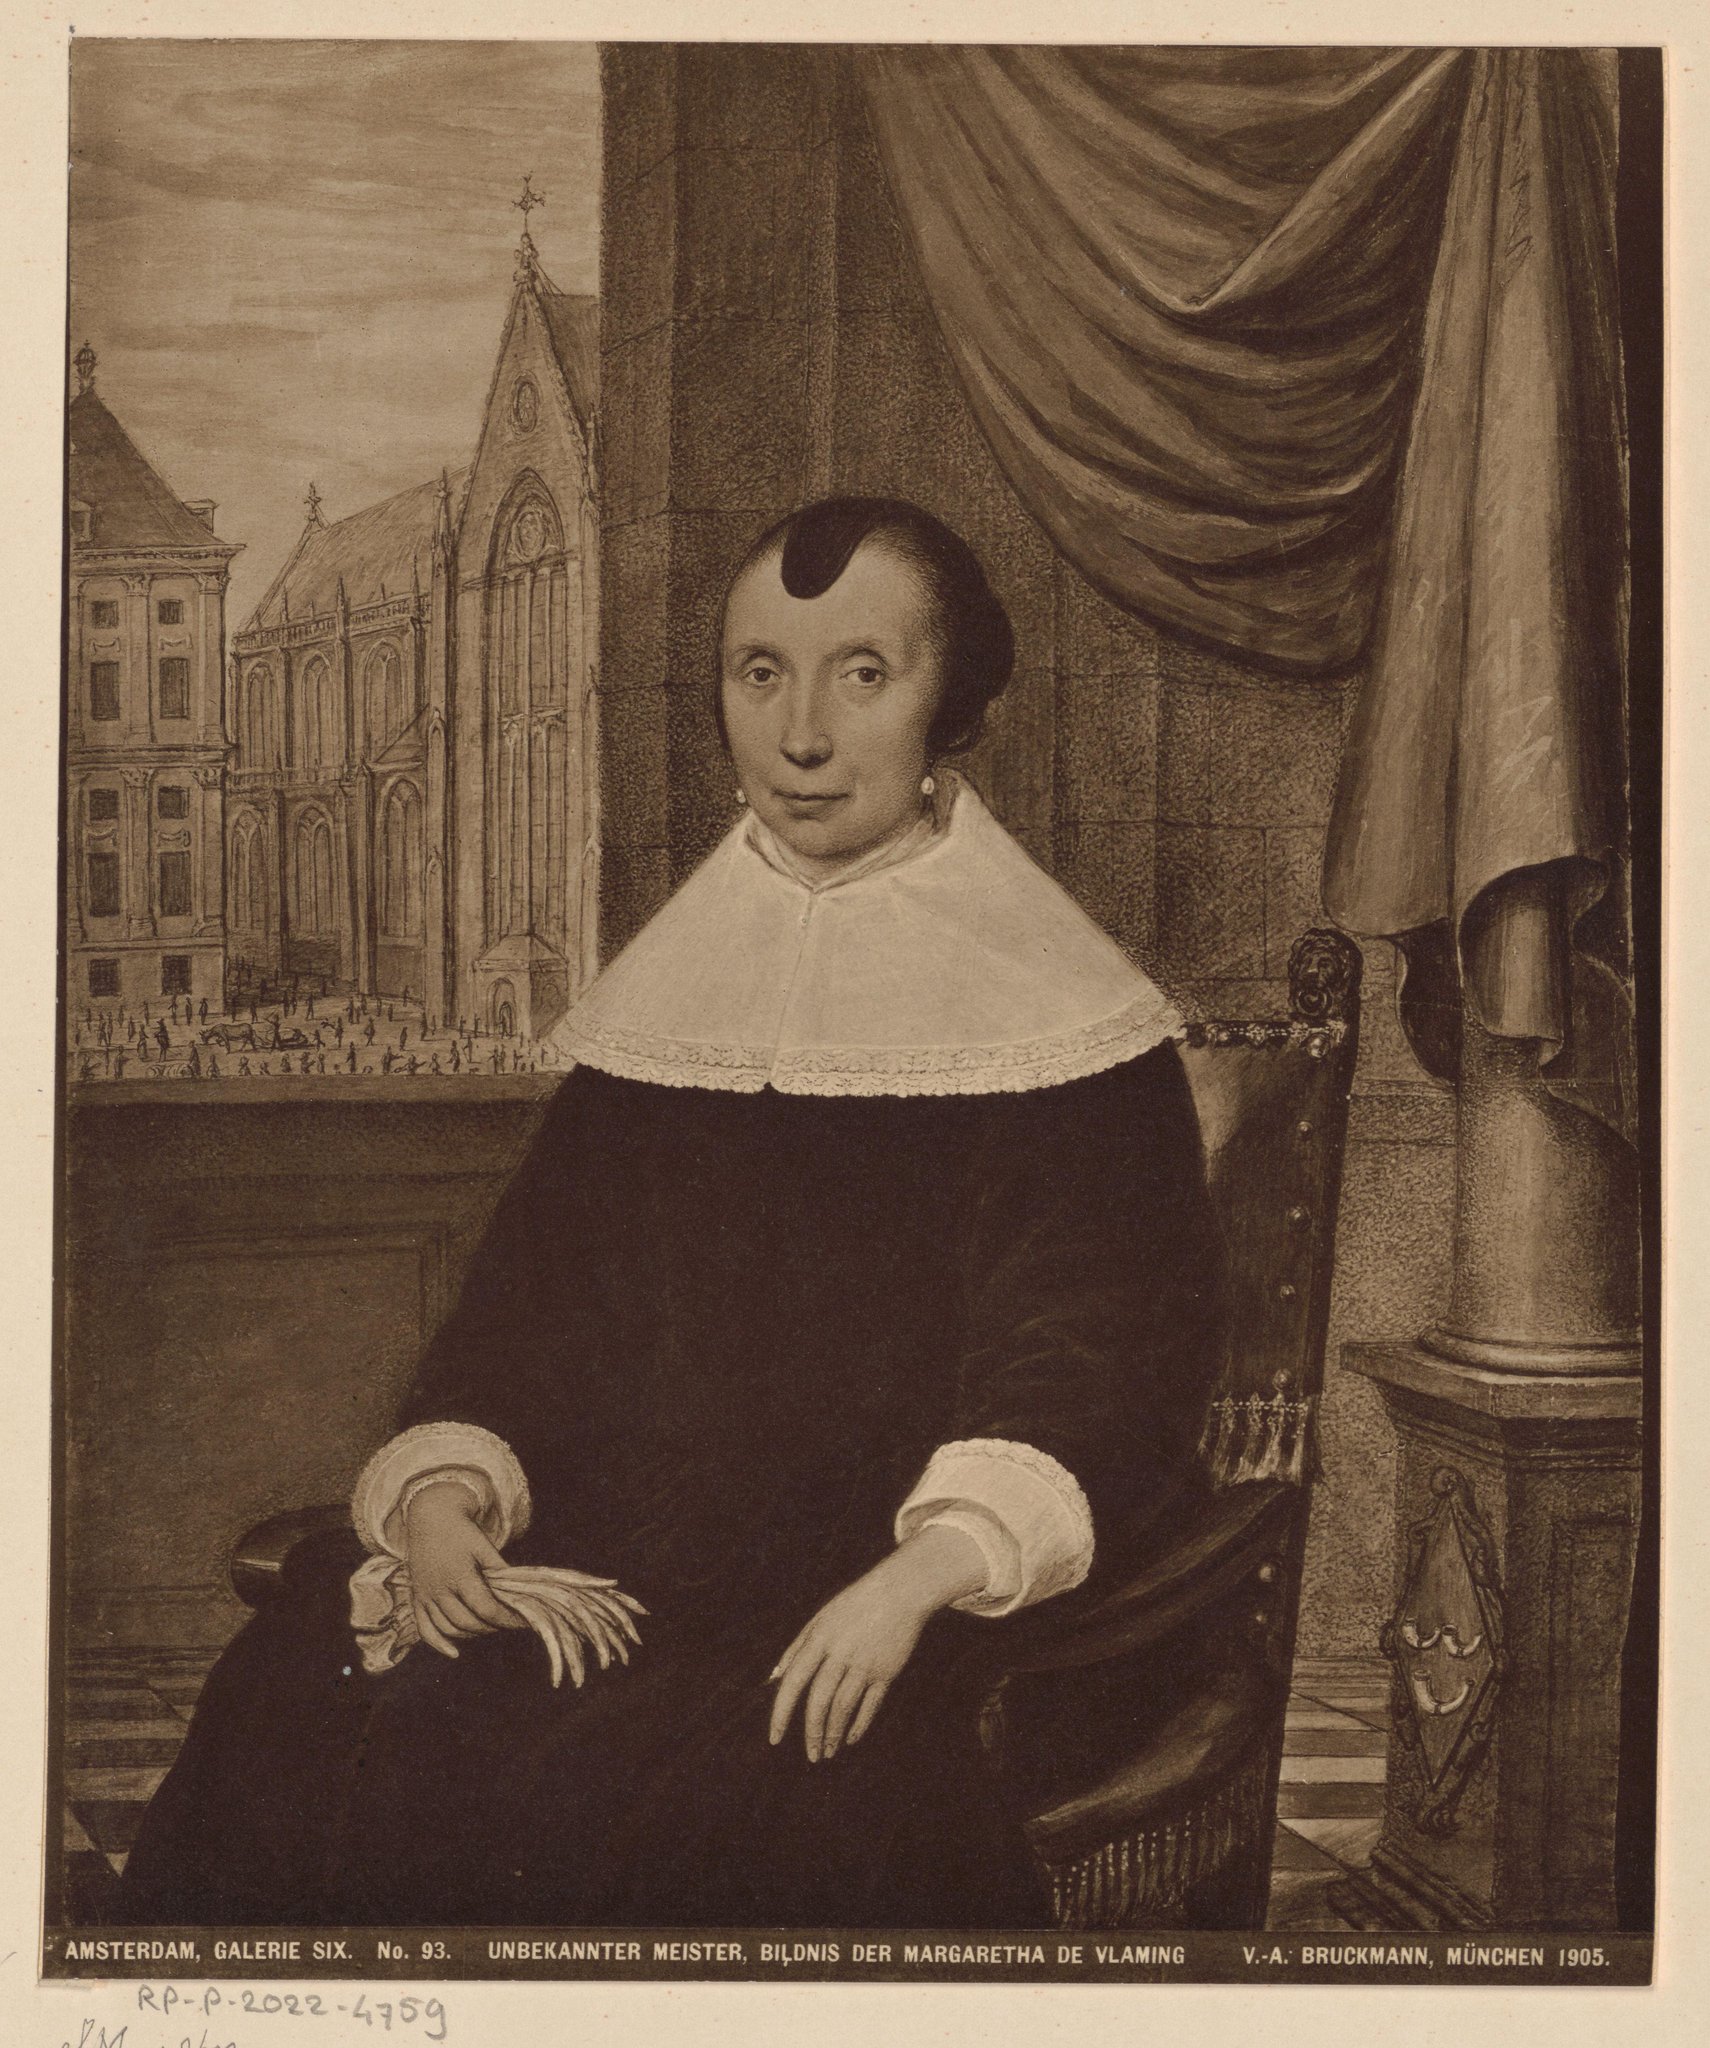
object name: photomechanical print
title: Portret van Margaretha de Vlaming van Oudtshoorn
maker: Anonymous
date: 1905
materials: paper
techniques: photograph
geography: munich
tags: amsterdam, historical persons - bb - woman